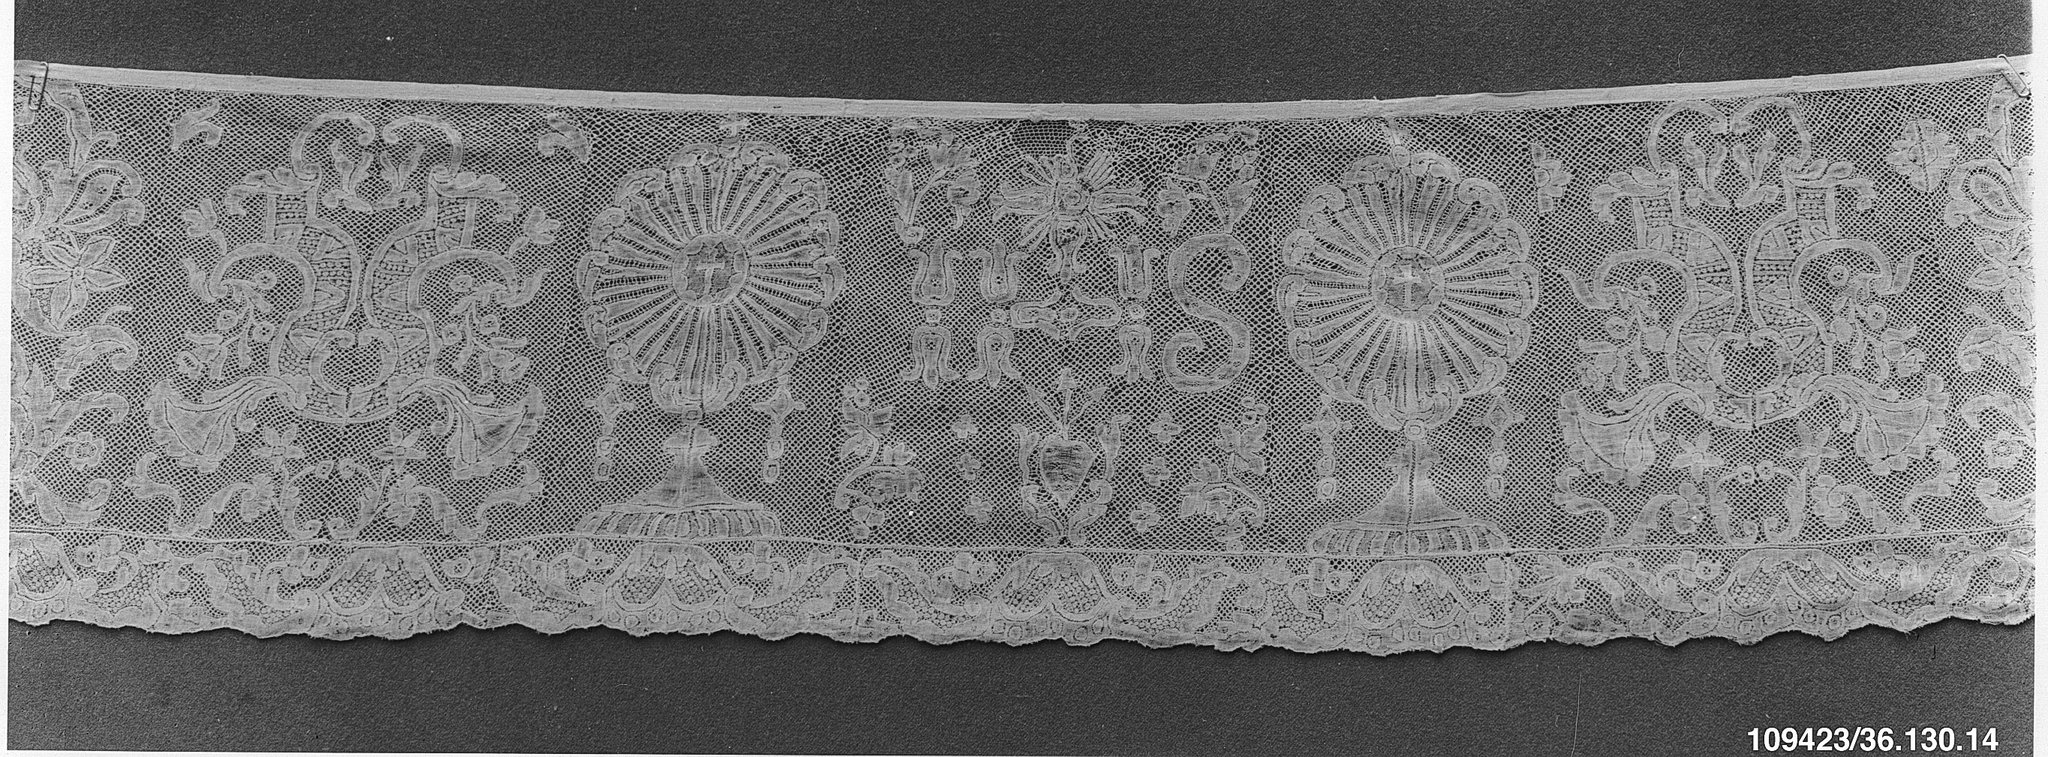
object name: border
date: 1701-1800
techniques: lace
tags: flowers